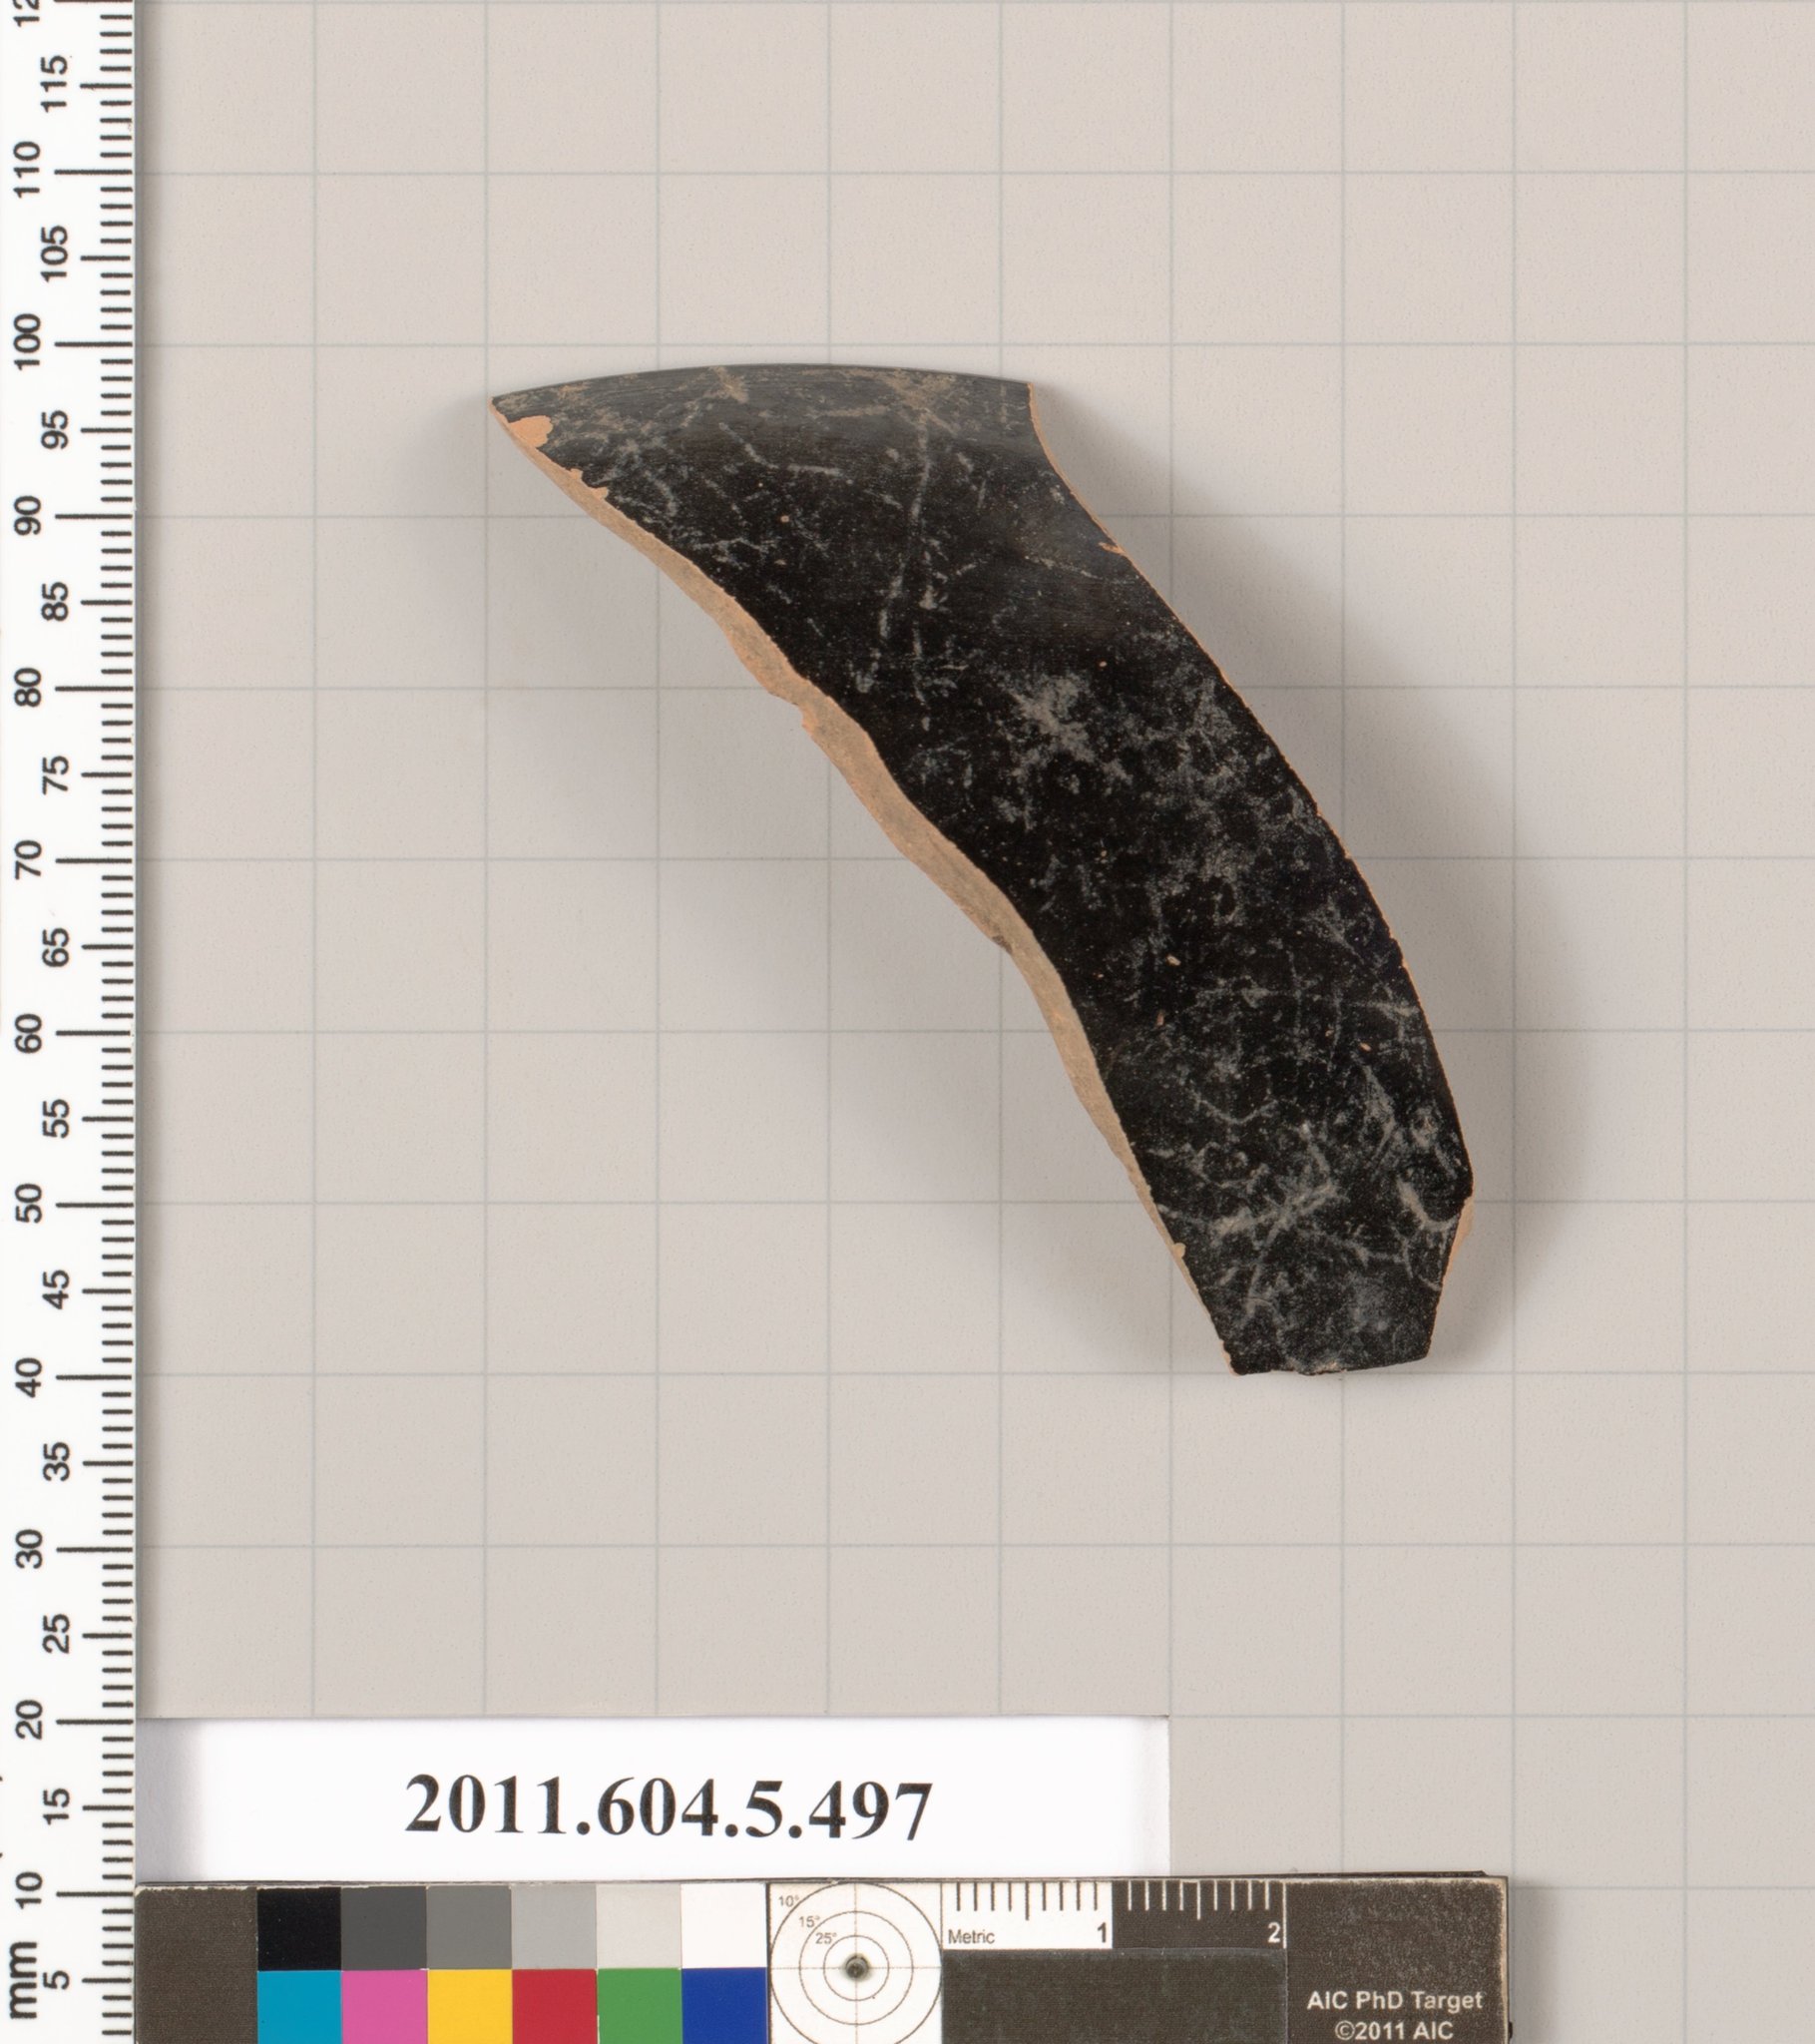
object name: kylix fragment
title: Terracotta rim fragment of a kylix (drinking cup)?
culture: greek, attic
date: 600-401 BCE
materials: terracotta